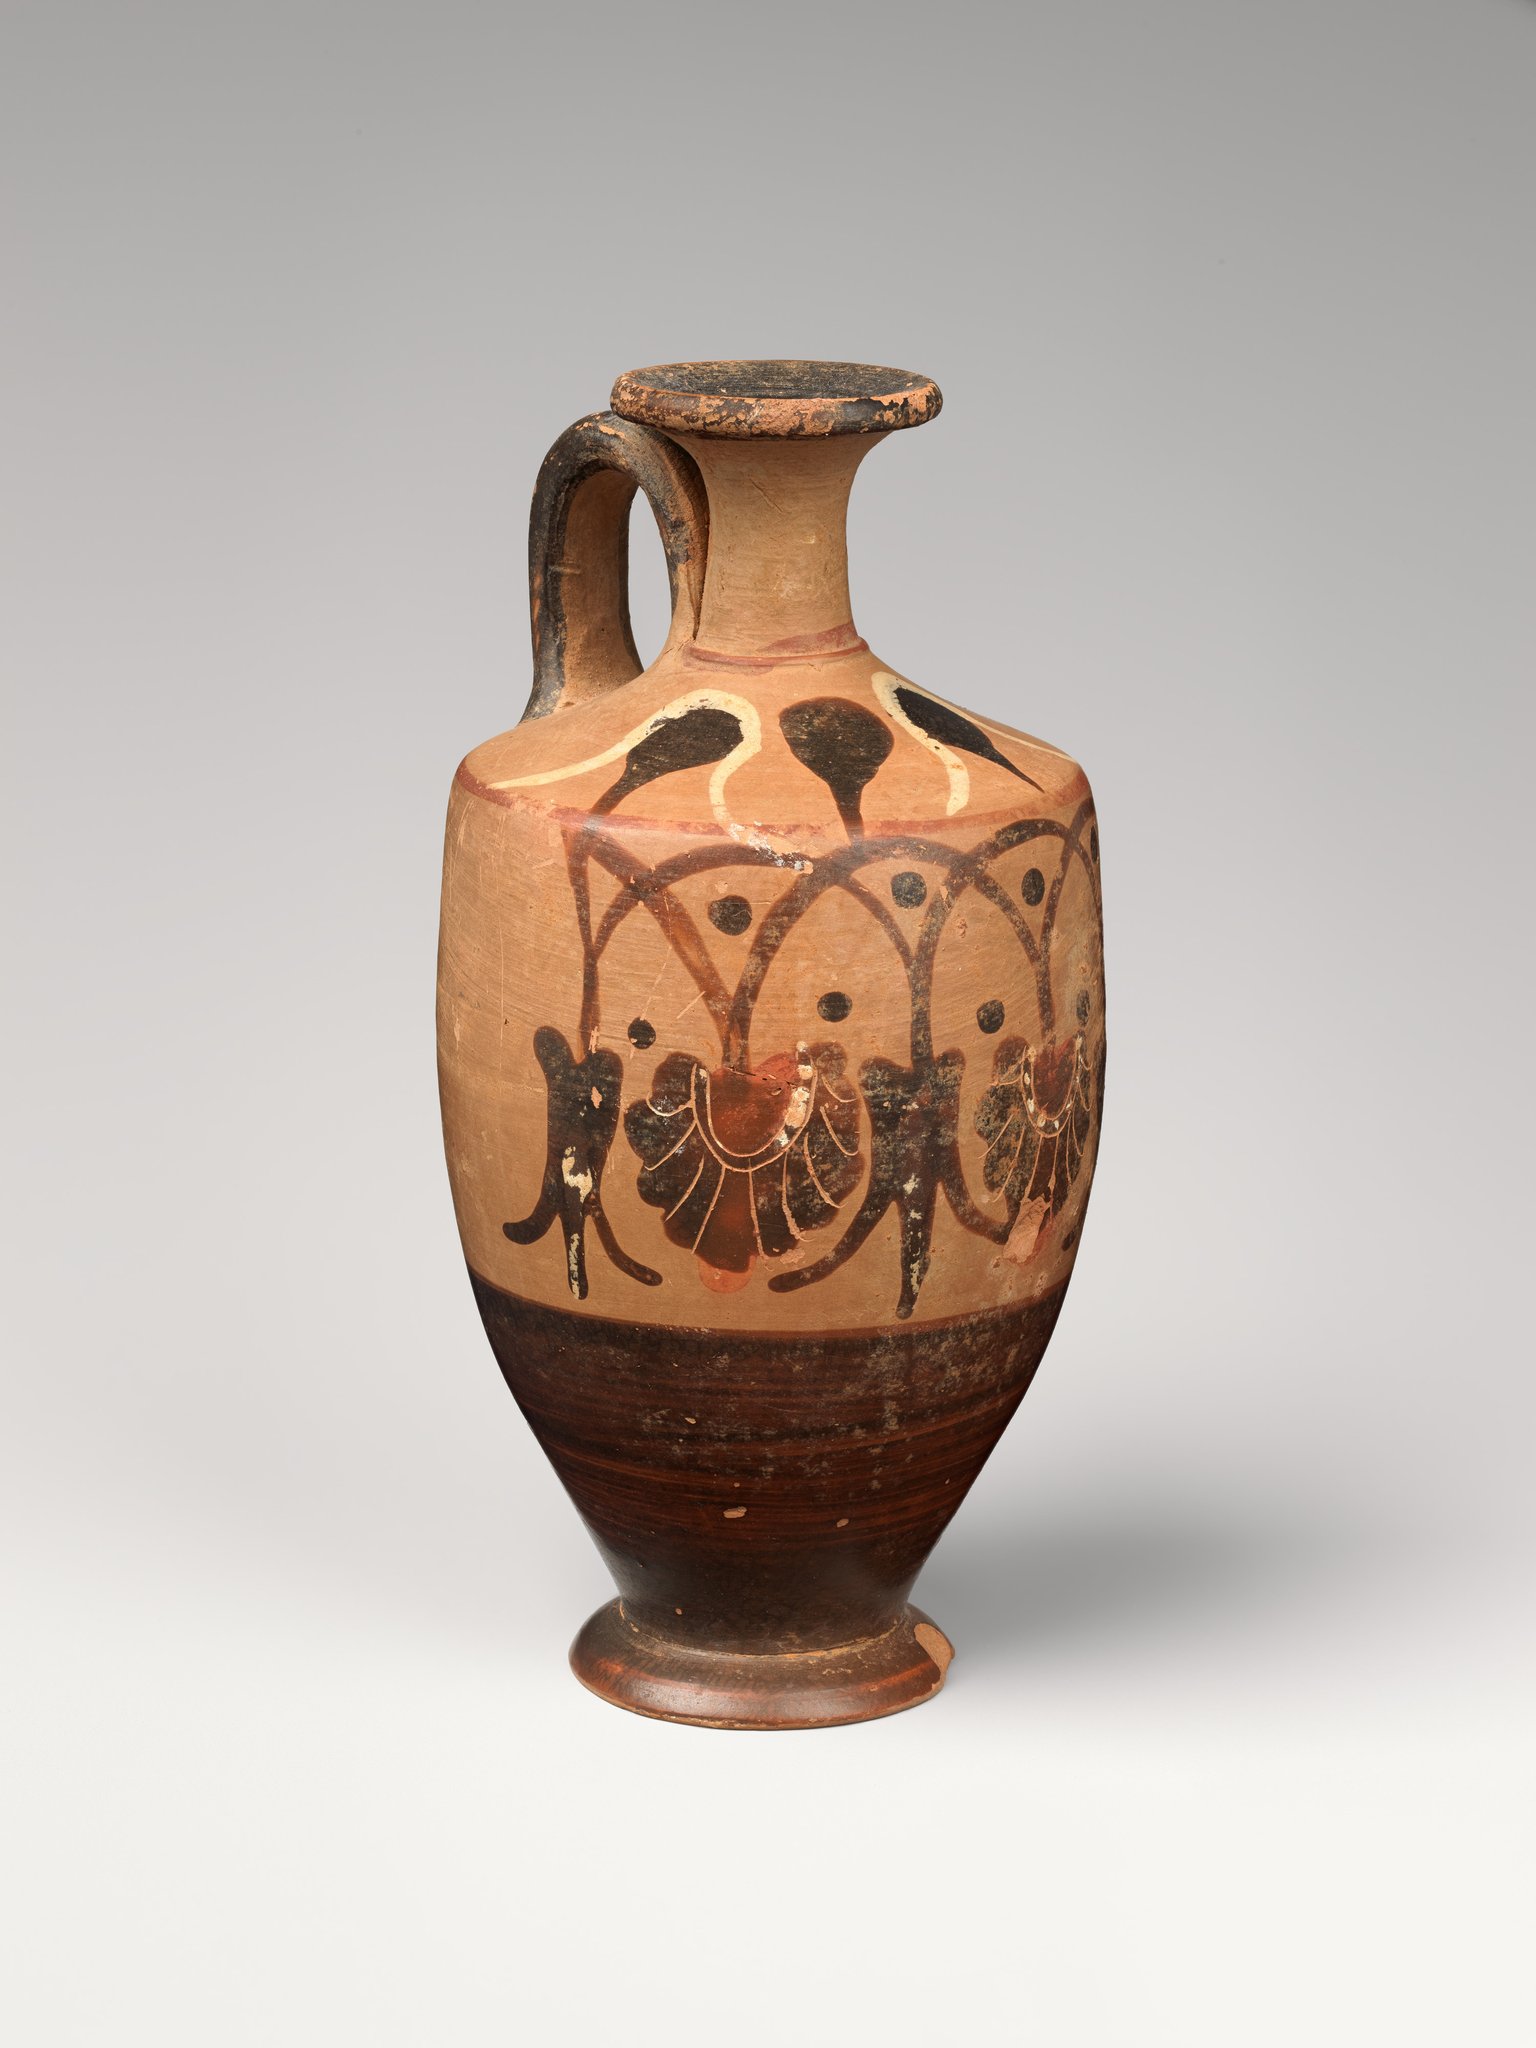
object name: lekythos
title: Terracotta lekythos (oil jar)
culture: greek, euboean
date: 534-501 BCE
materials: terracotta